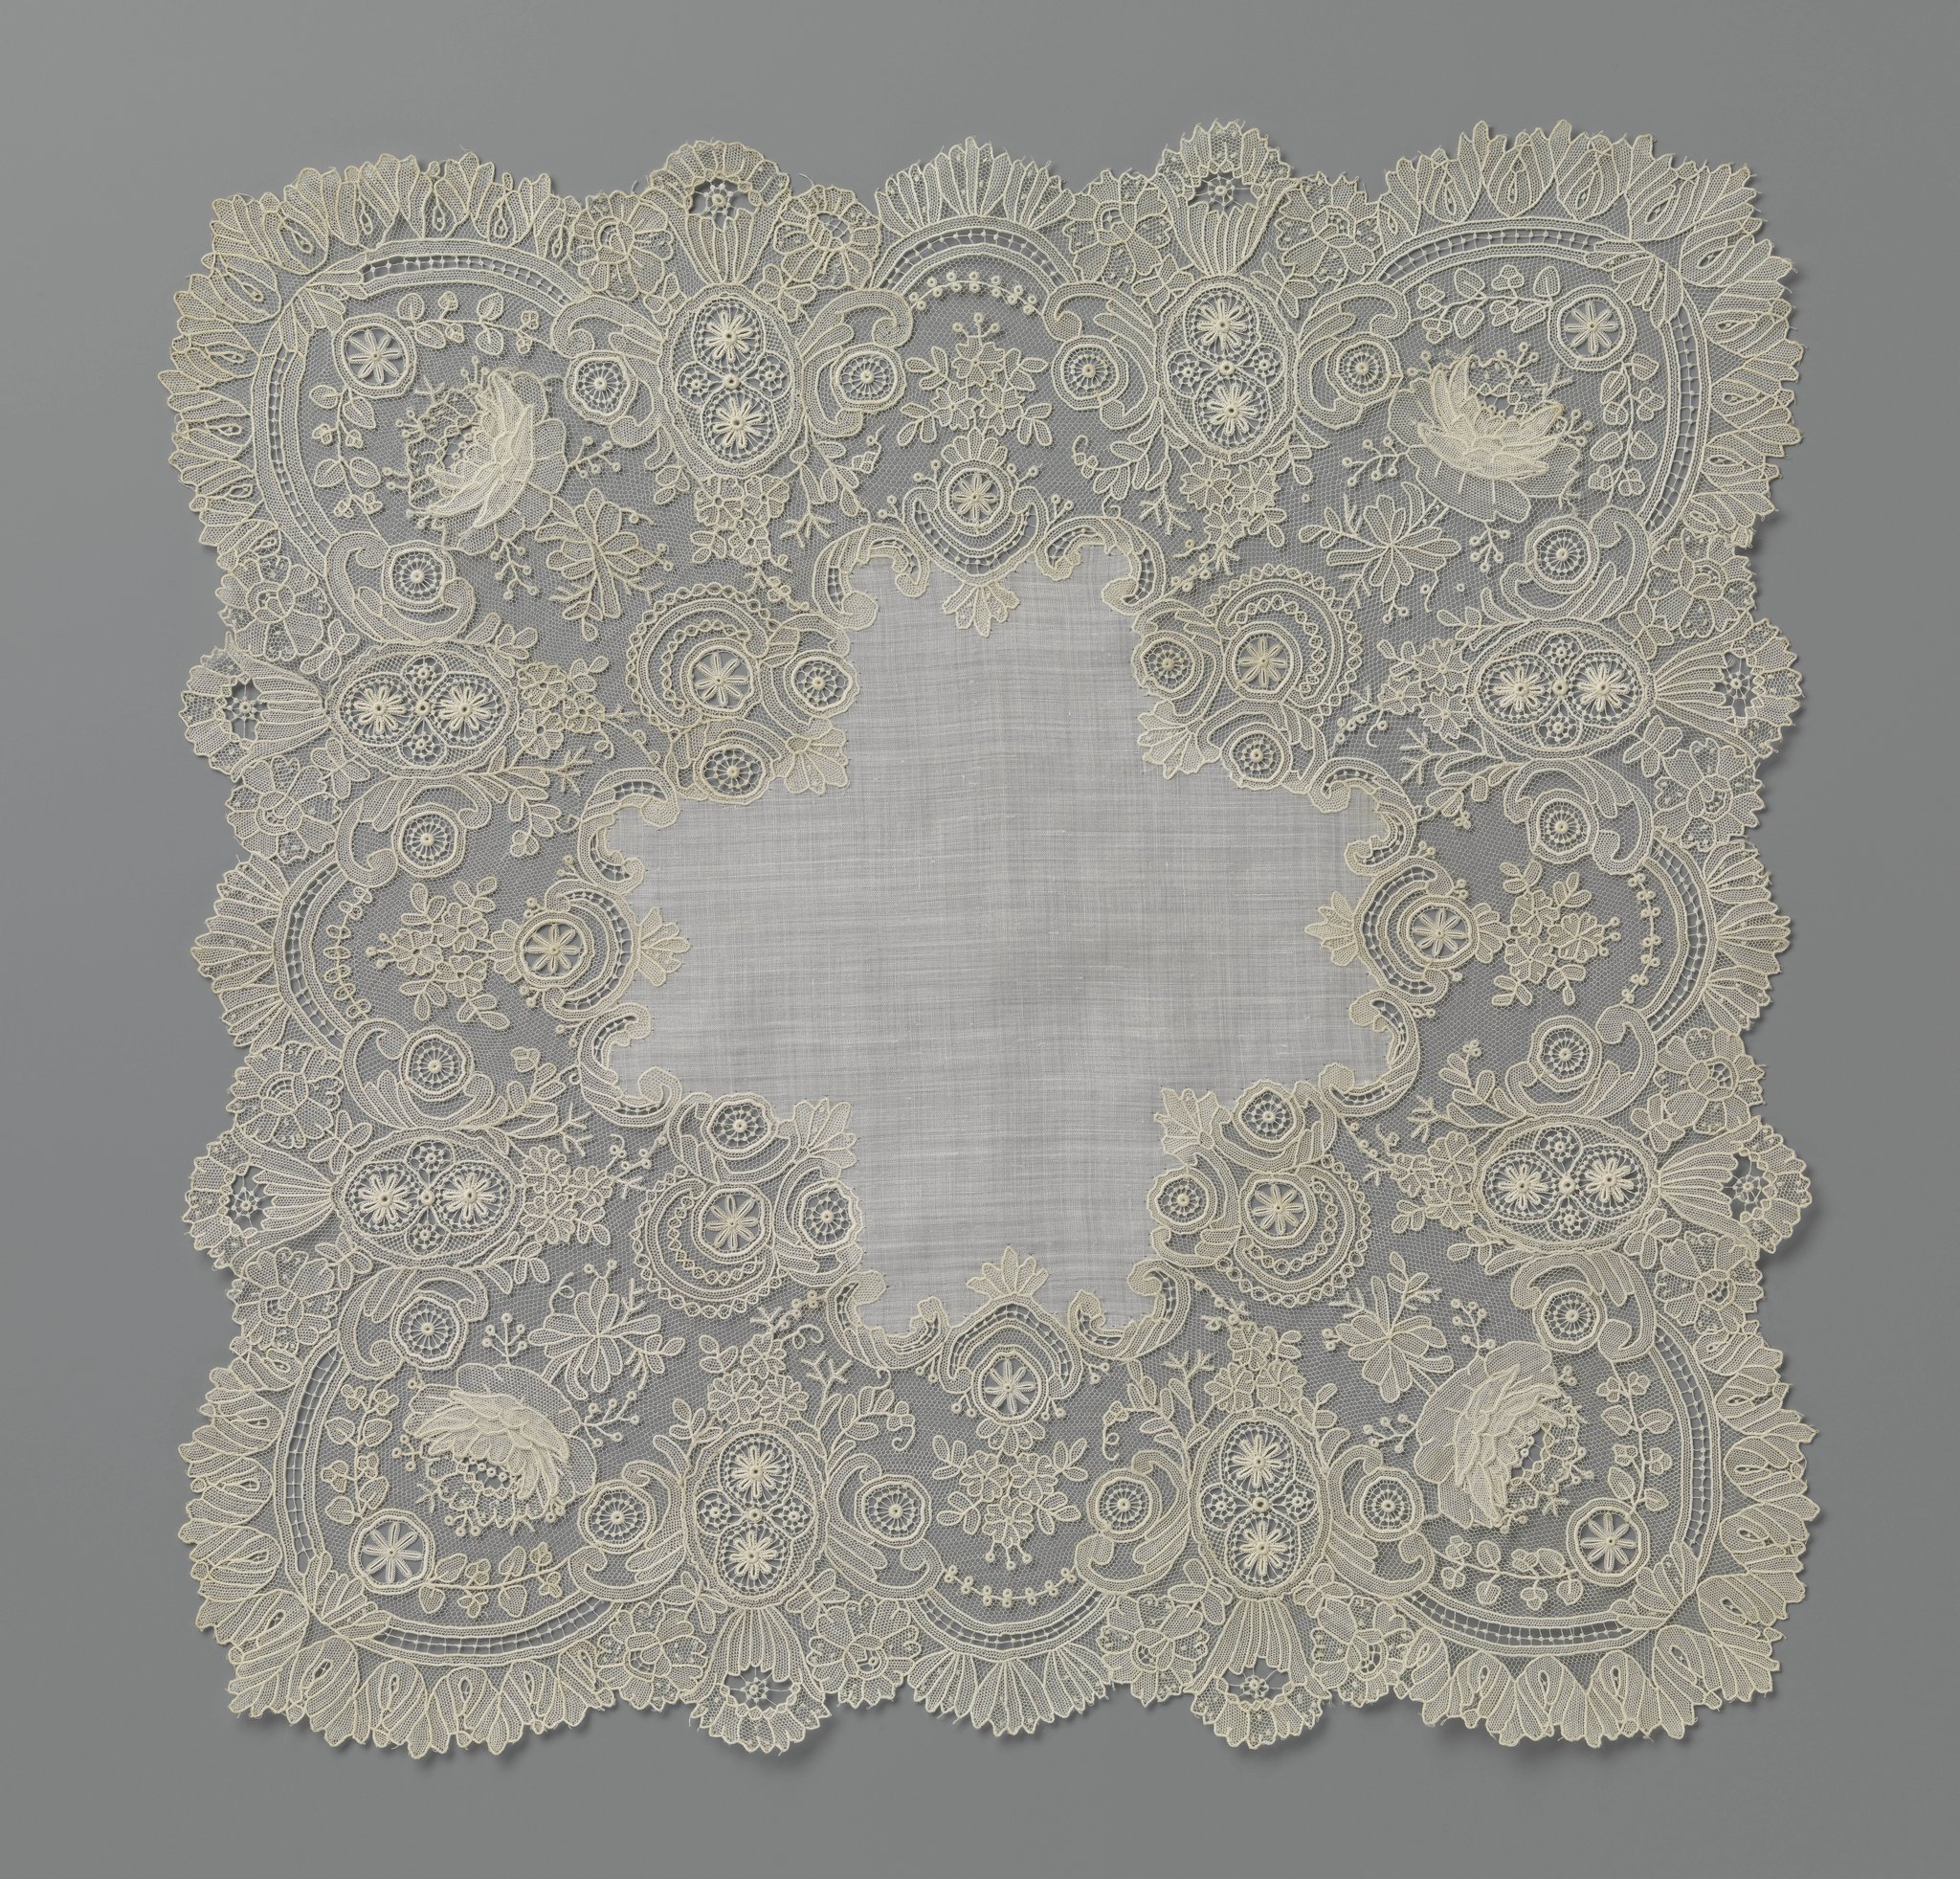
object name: handkerchief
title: Zakdoek met een rand van naaldkant met acht ovaaltjes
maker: Anonymous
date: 1870-1890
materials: linen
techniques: lace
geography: brussels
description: Zakdoek met een rand van naturelkleurige naaldkant, Brusselse gaaskant. Rondom een klein, kruisvormig batisten midden loop een kanten rand met acht diepe schulpen. Deze worden door acht, in c-voluten gevatte, staande ovaaltjes gescheiden, waarin onder andere gesloten gewerkte sterretjes voorkomen. De schulpen zijn gevormd door 'spoorrails', waarbuiten kelkjes en dubbele, toegeklapte acanthusblaadjes afhangen. Onder de ovaaltjes hangt een kelkbloem tussen twee roosjes. In de hoekschulpen staat telkens een roos met drievoudige reliëfblaadjes. Kleine c-voluten vormen de binnenrand.